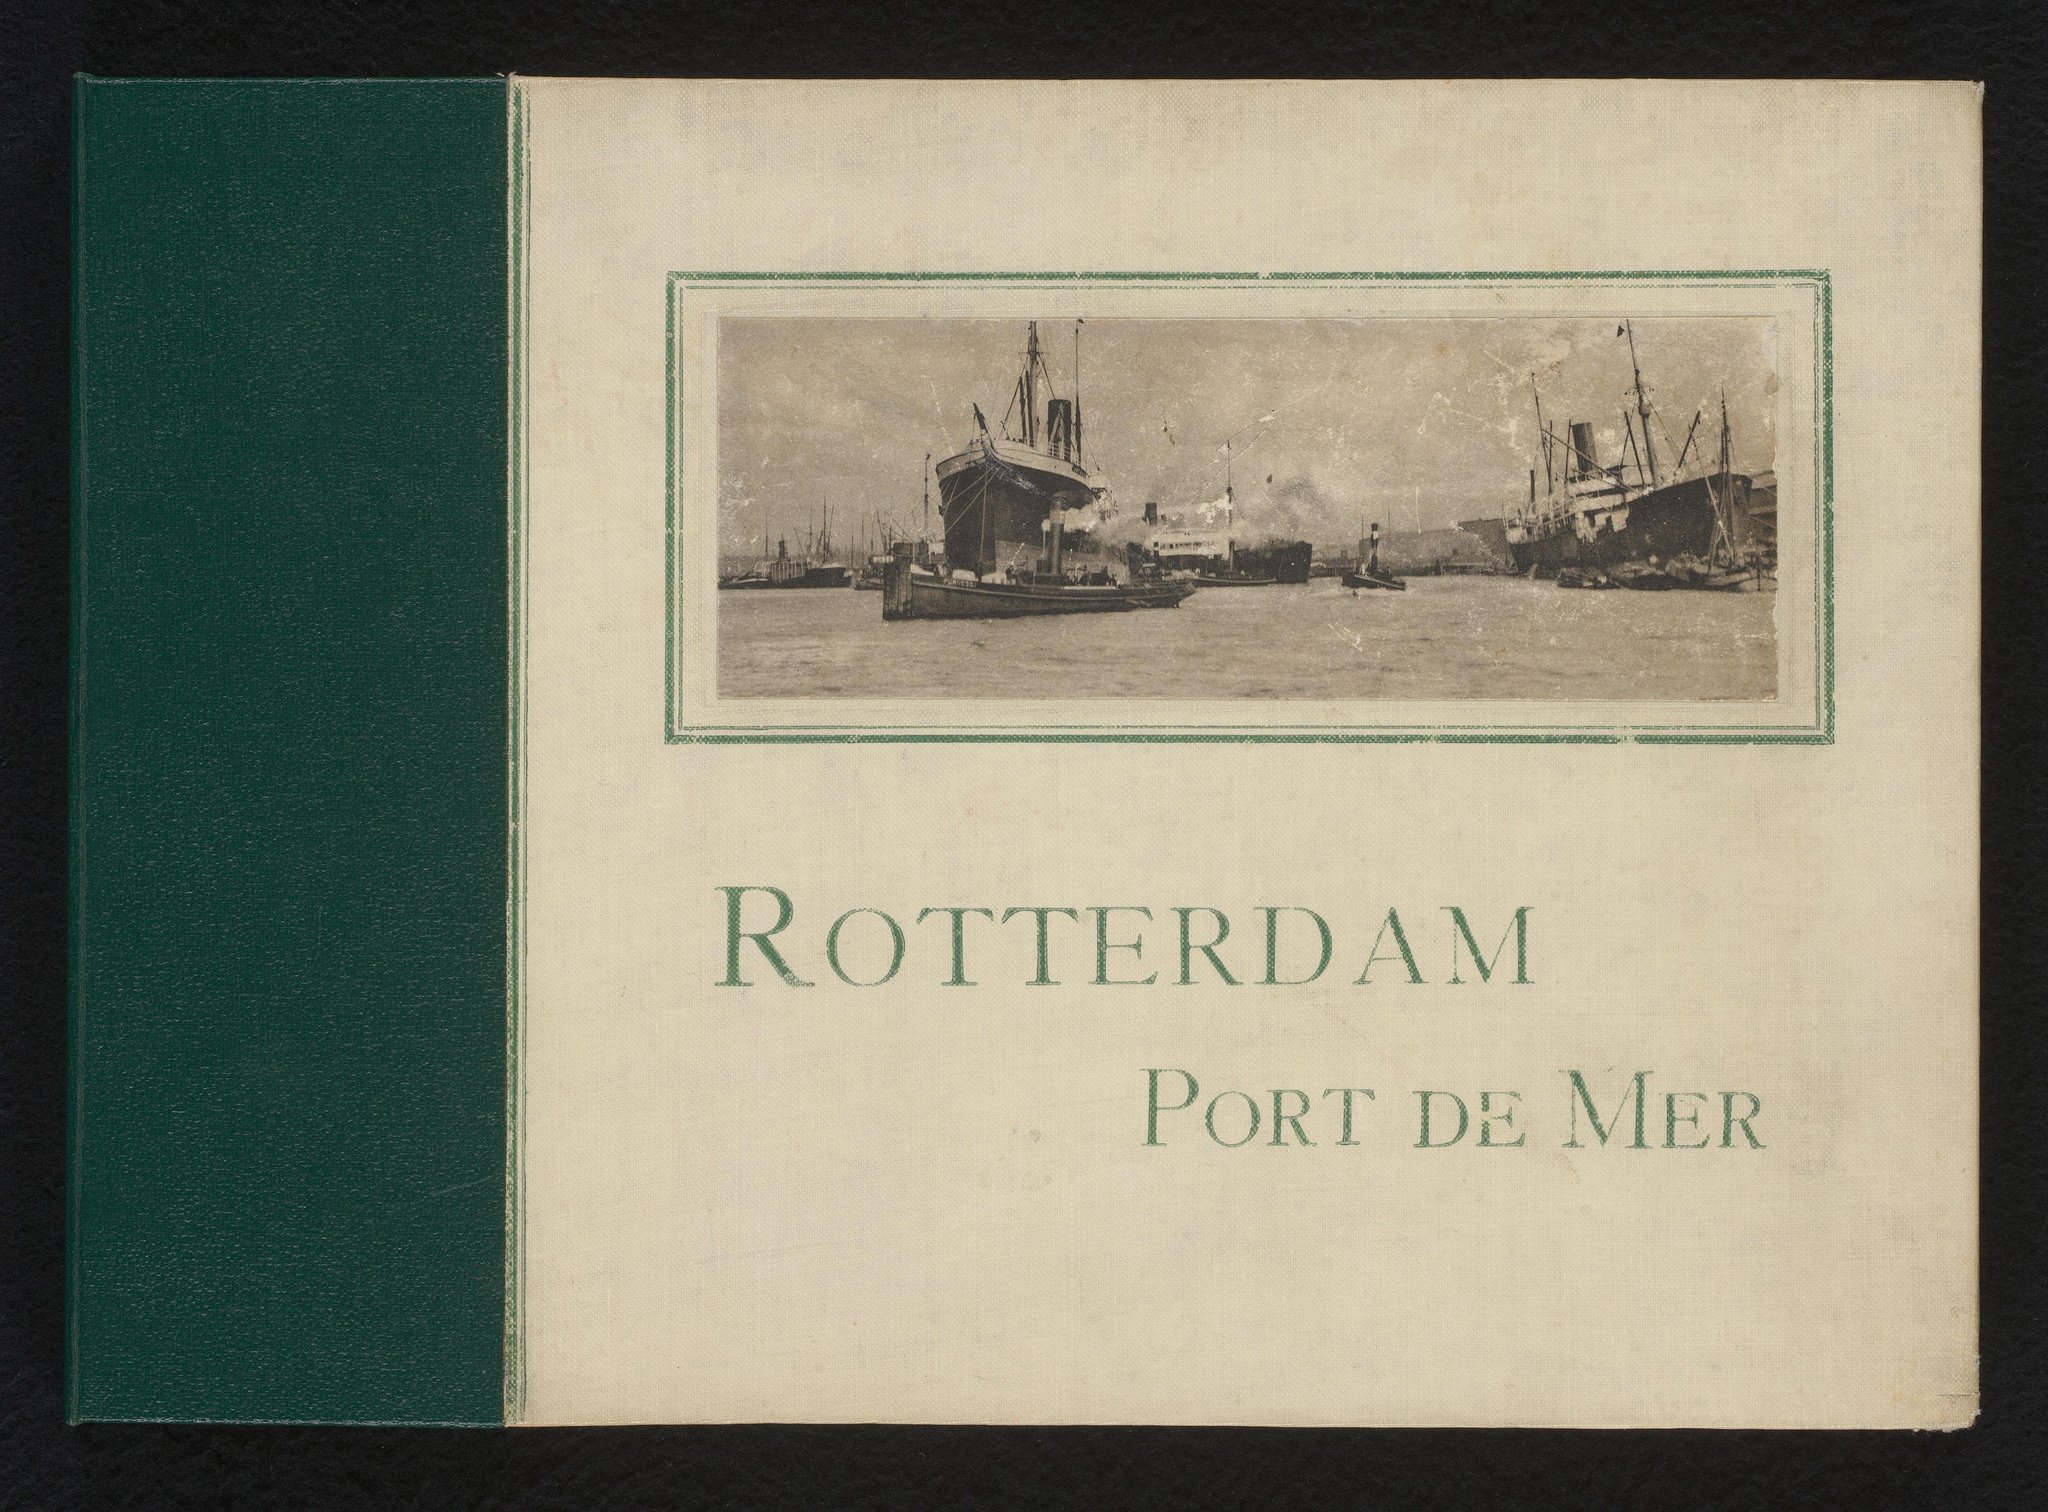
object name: photomechanical print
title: Verschillende schepen in de haven van Rotterdam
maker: Anonymous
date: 1902-1907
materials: paper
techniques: photograph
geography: rotterdam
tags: harbour, ships (in general) - cc - more than one ship, rotterdam